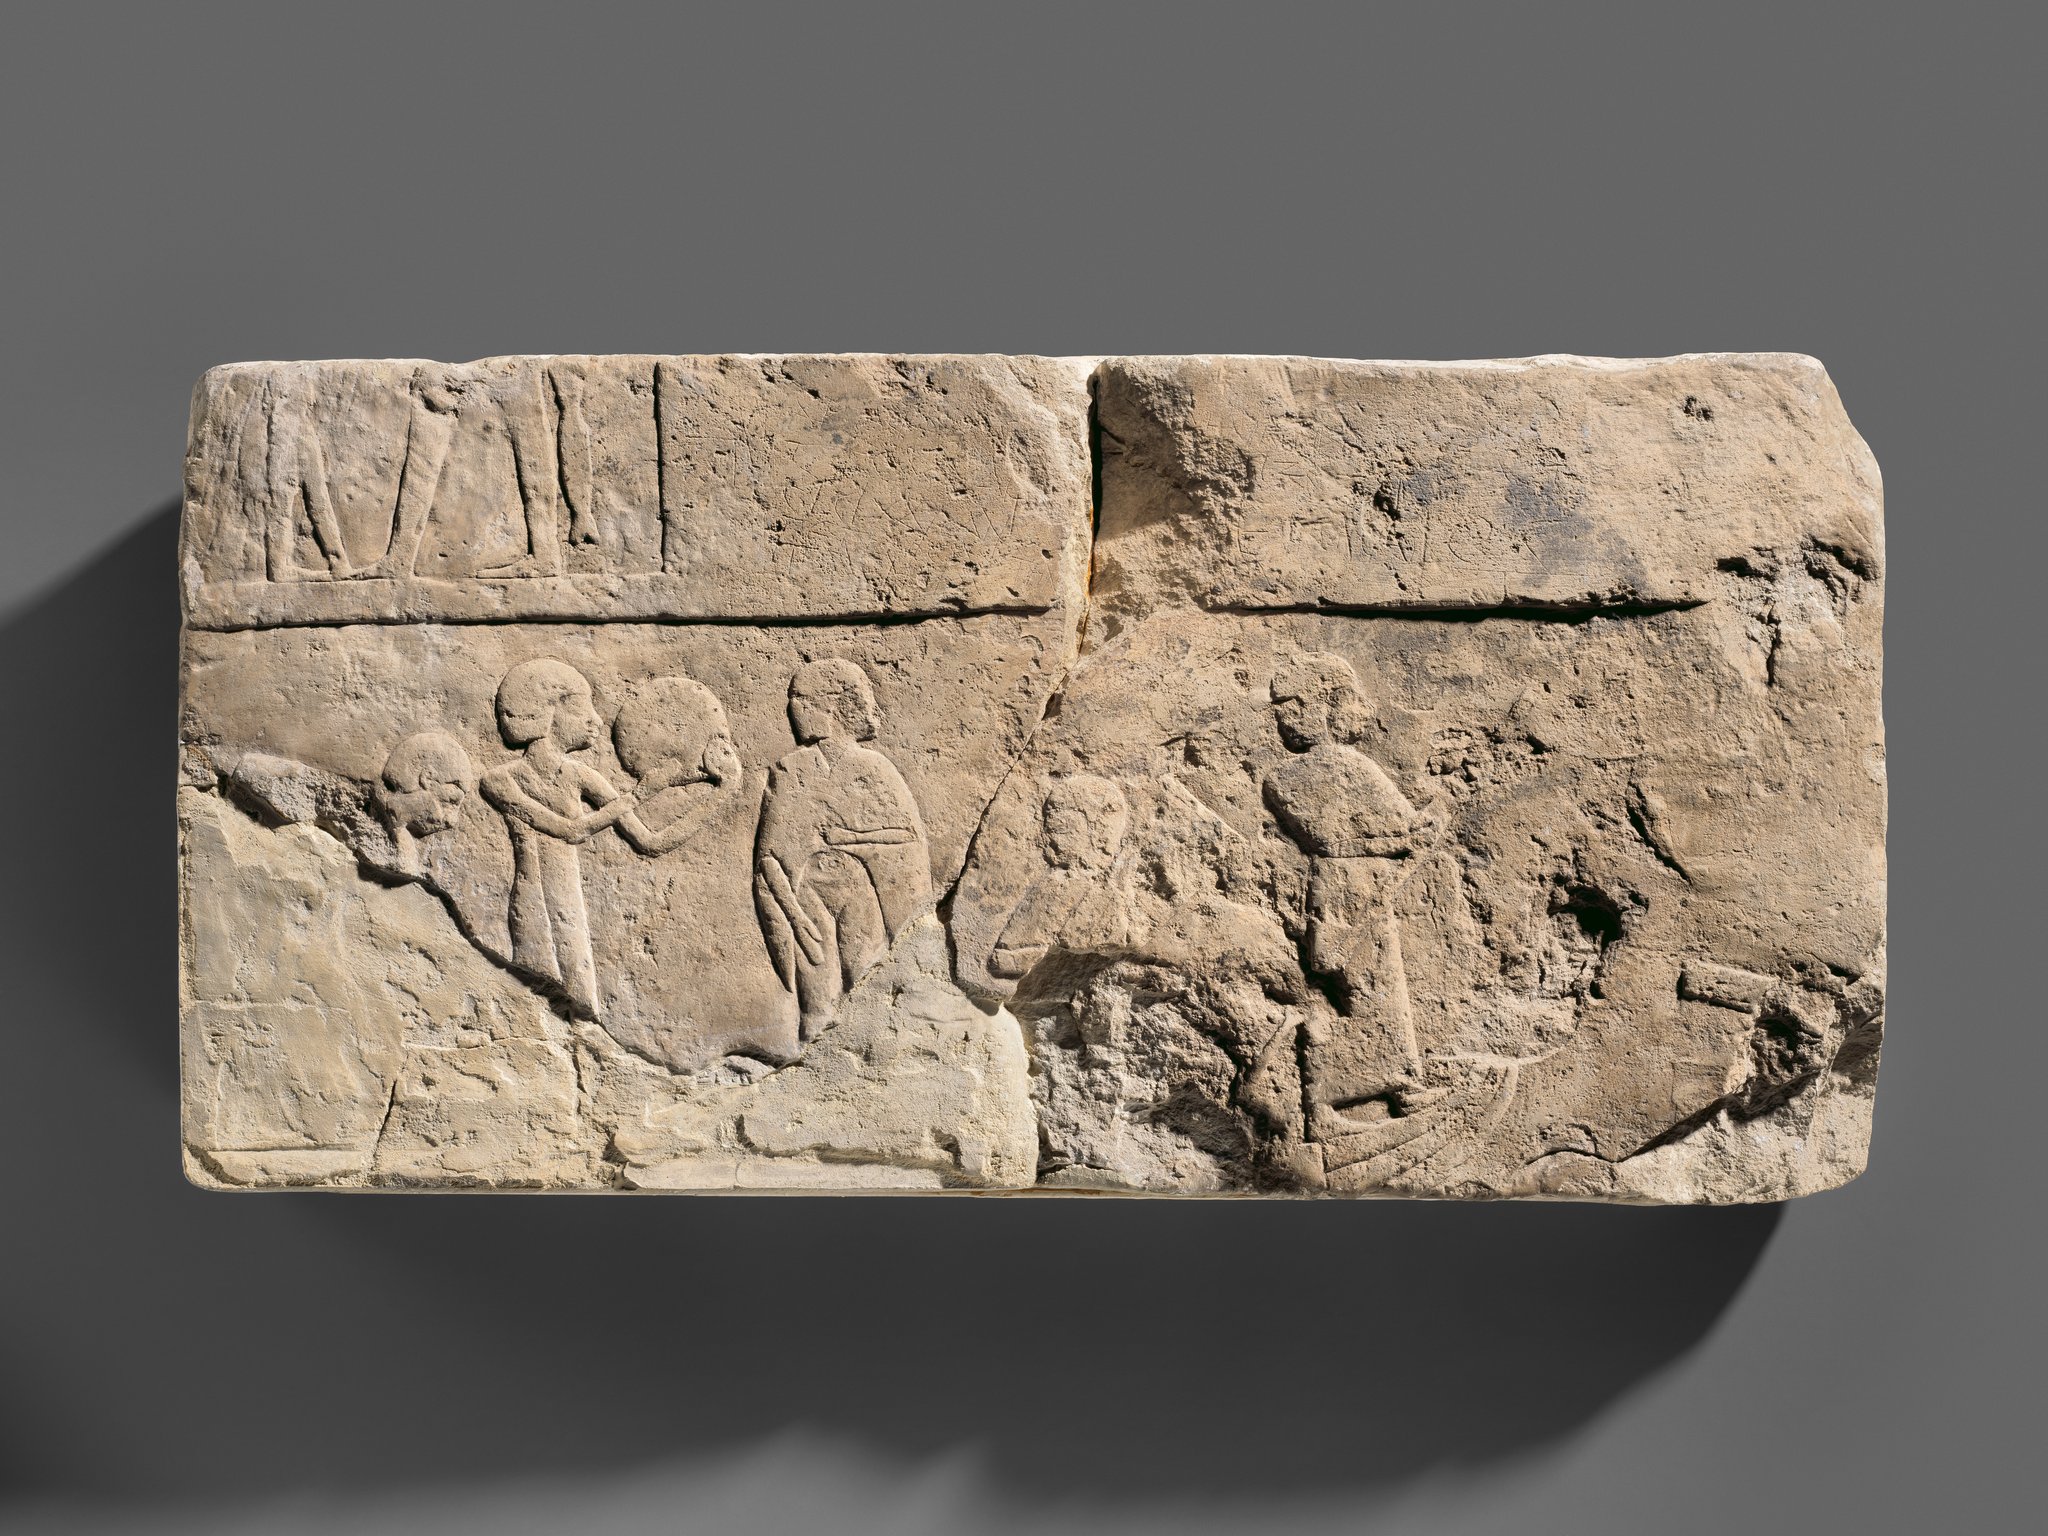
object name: relief, woman in a boat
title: Relief of Women in a Boat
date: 595-550 BCE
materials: limestone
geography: memphite region or delta